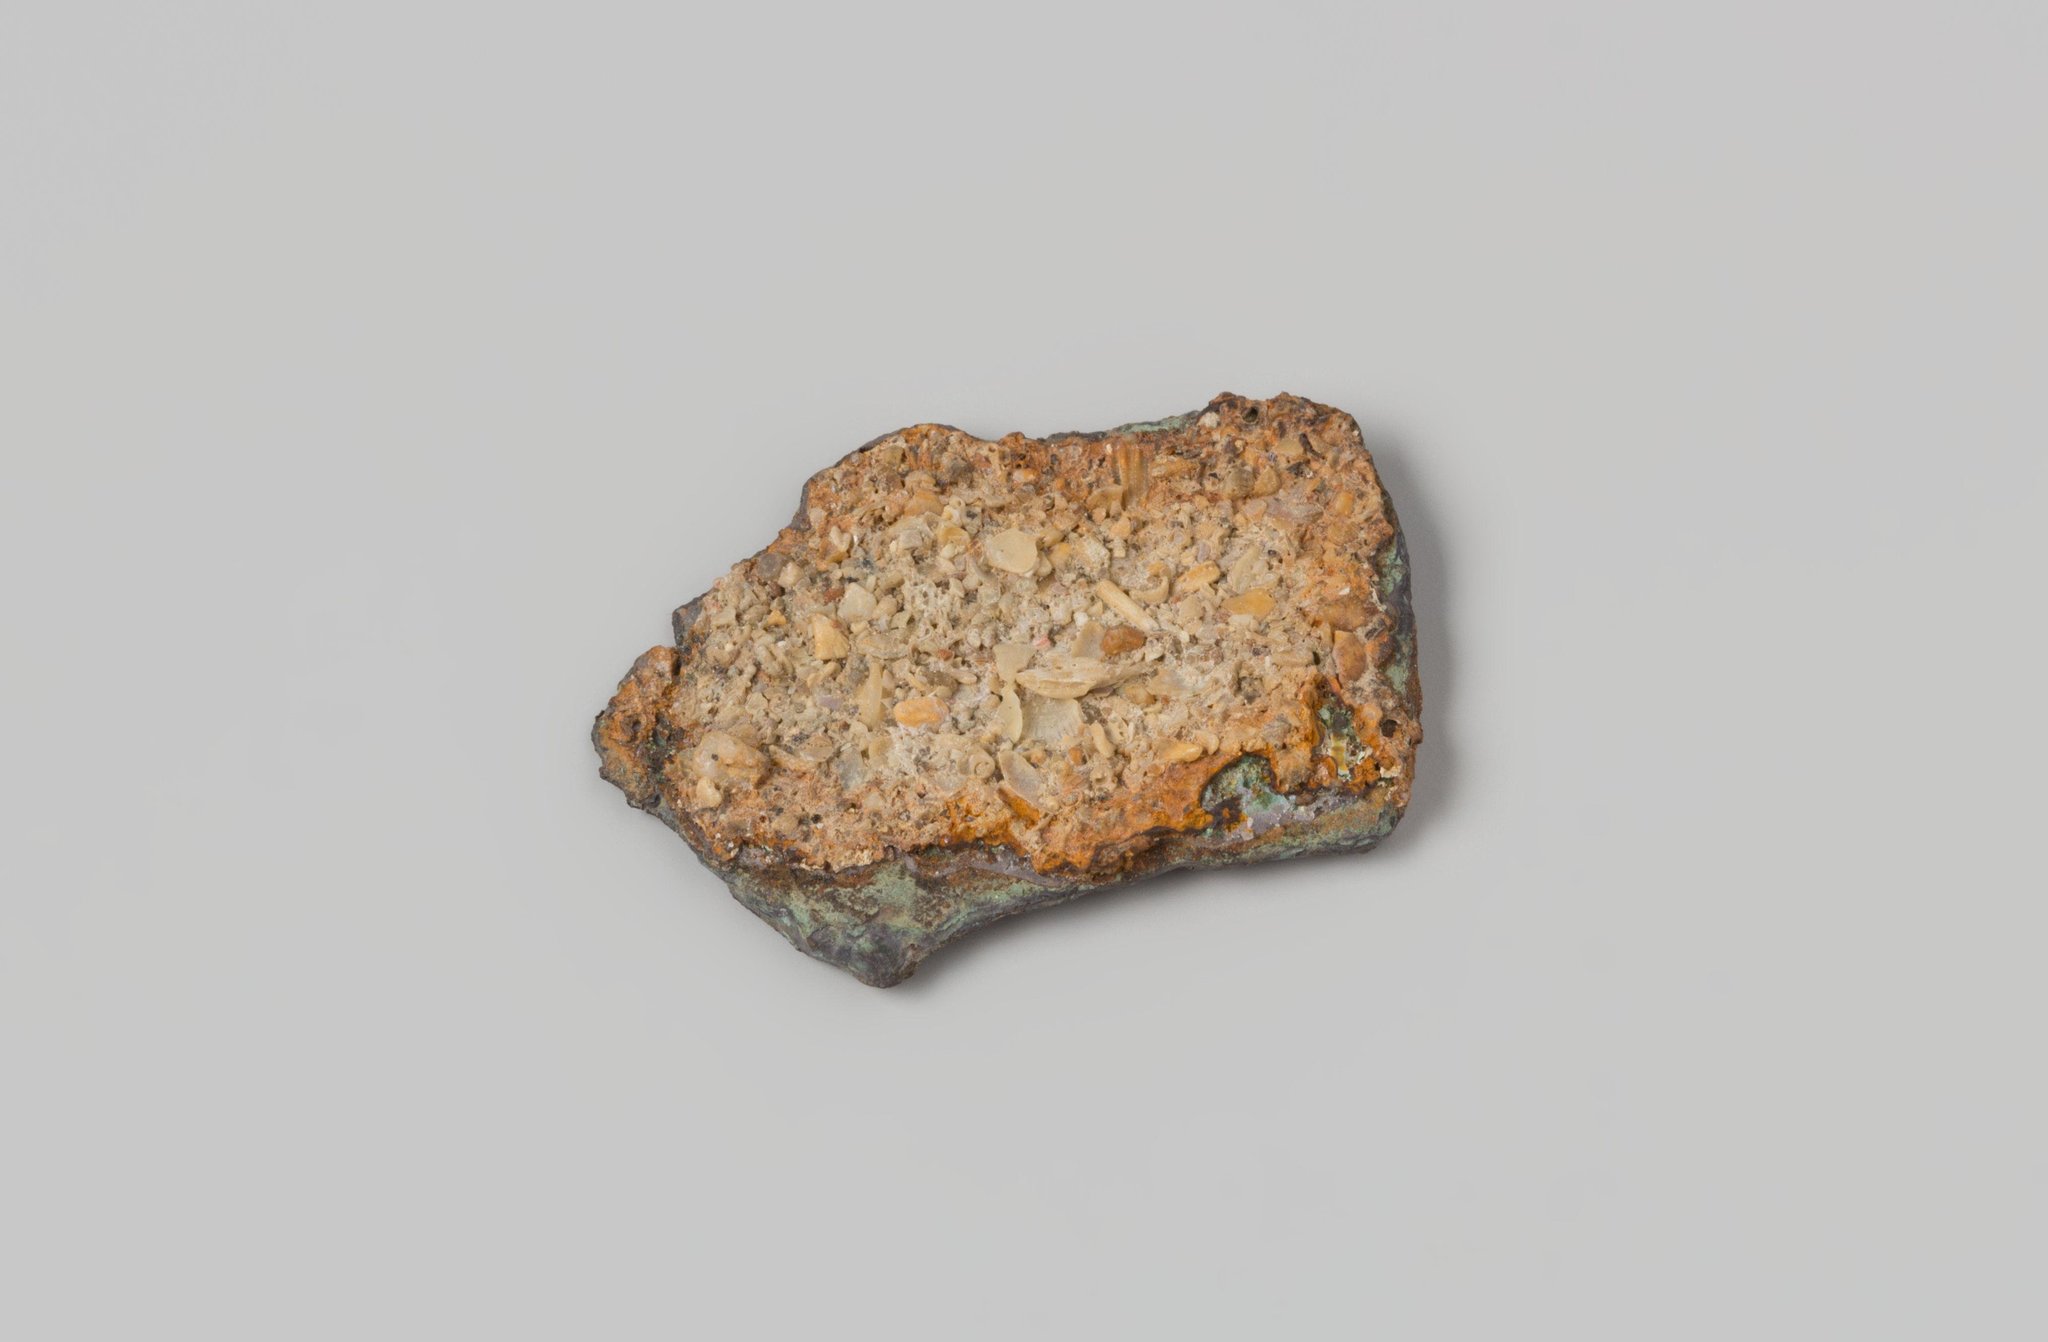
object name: scheepswrakvondst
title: Fragment van zilver uit het wrak van de Oost-Indiëvaarder Hollandia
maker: Anonymous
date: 1700-1743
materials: silver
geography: netherlands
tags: verenigde oostindische compagnie, hollandia (schip), annet